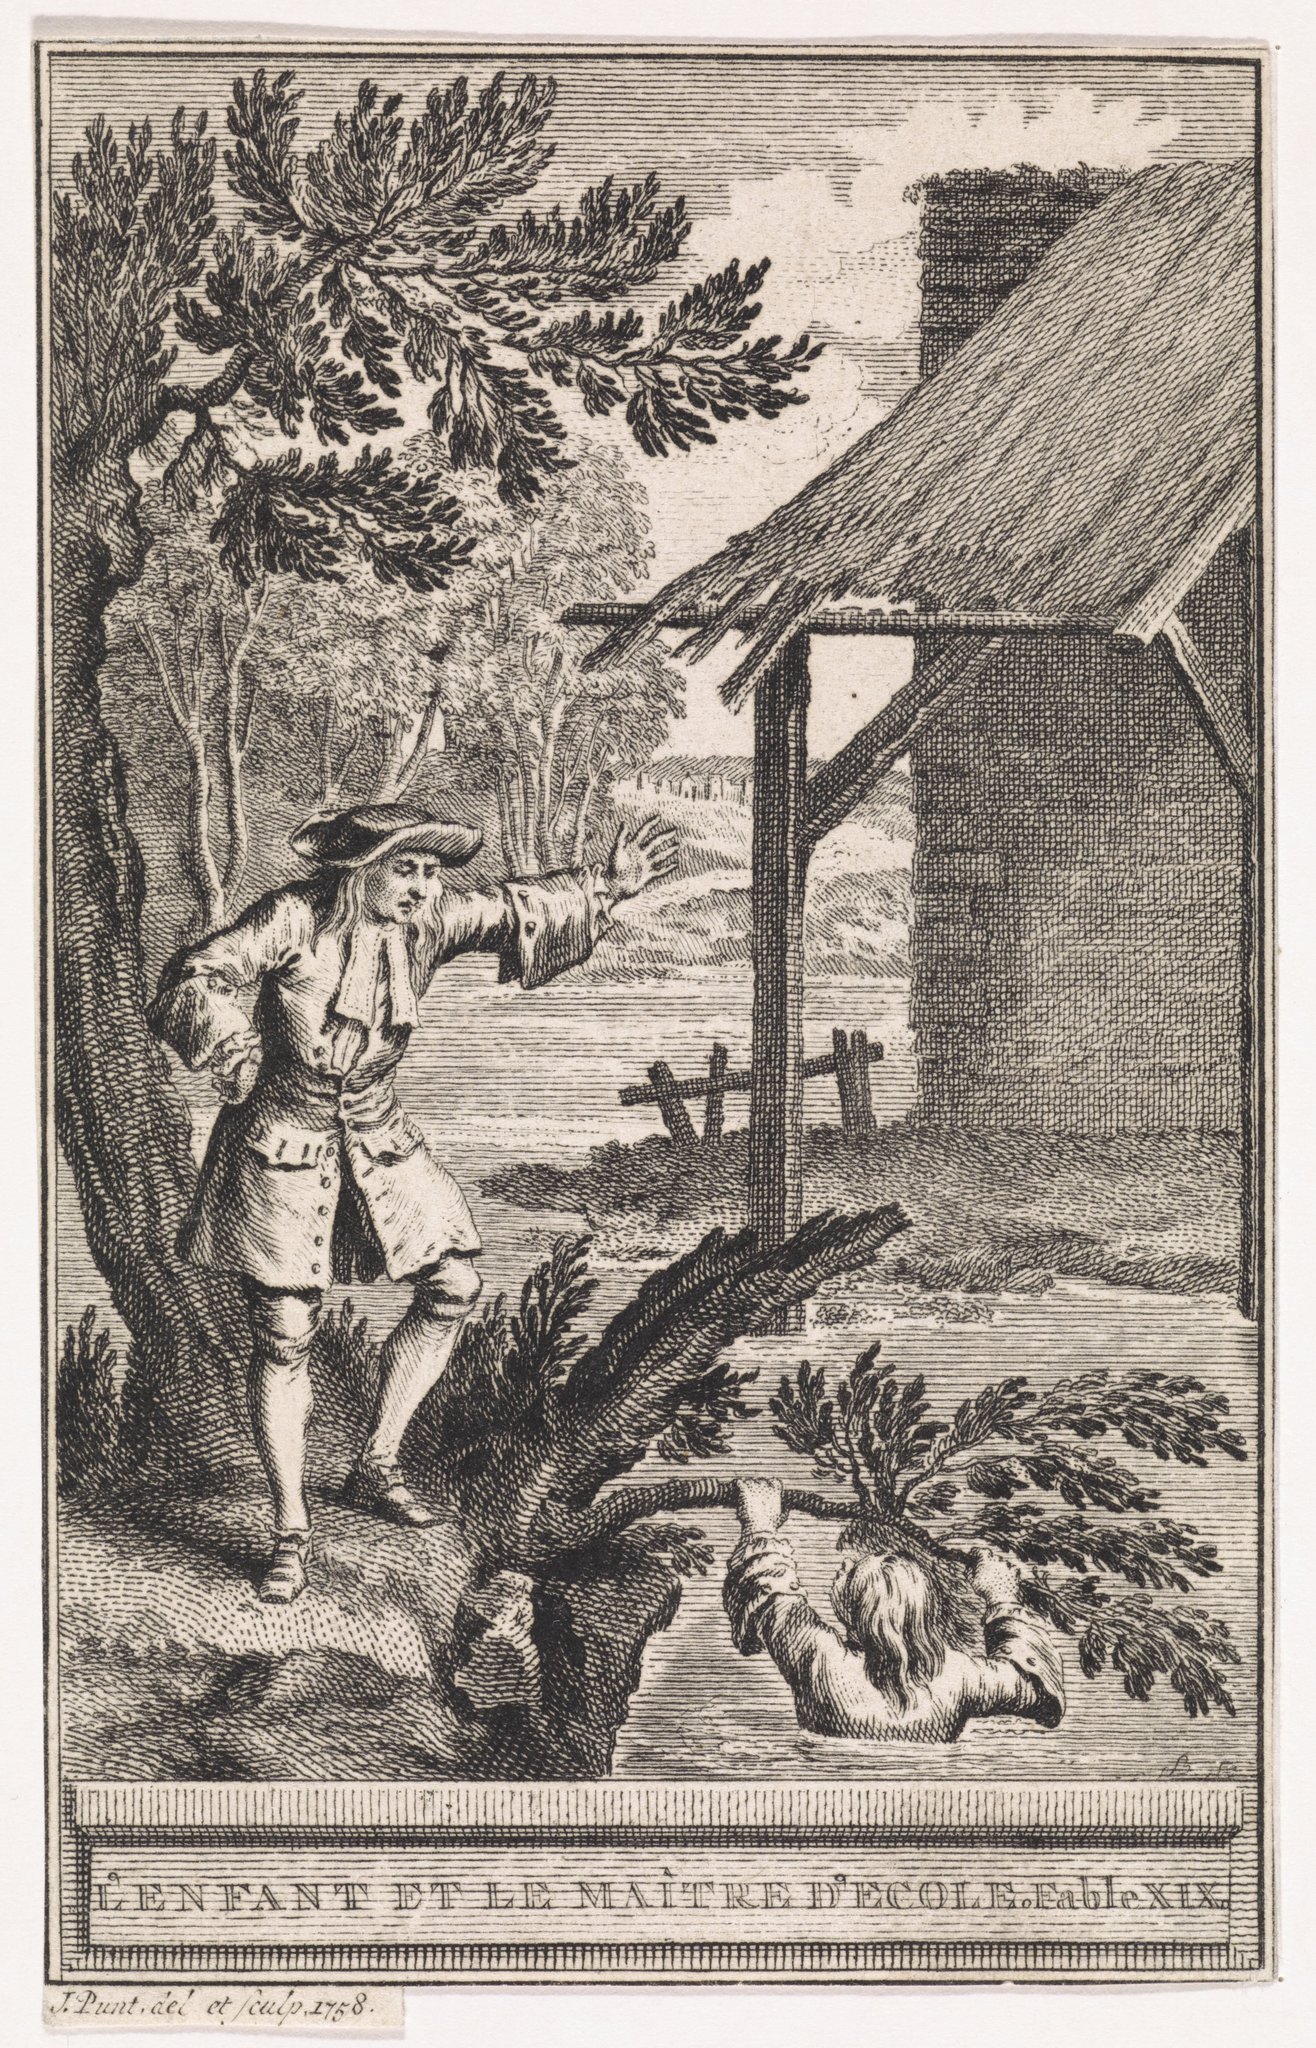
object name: book illustration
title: Jongen klampt zich vast aan tak in rivier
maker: jan punt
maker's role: draughtsman, print maker, publisher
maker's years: 1711-1779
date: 1758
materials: paper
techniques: engraving, etching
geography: amsterdam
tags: river bank, specific works of literature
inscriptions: collector's mark: Lugt 2228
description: Prent gebruikt als illustratie in een of meerdere edities van: La Fontaine, Jean de. Fables choisies, deel I, p. 34. Leiden: Elie Luzac, 1764-1786. En in de editie uit Amsterdam: J. van Gulik, 1802.